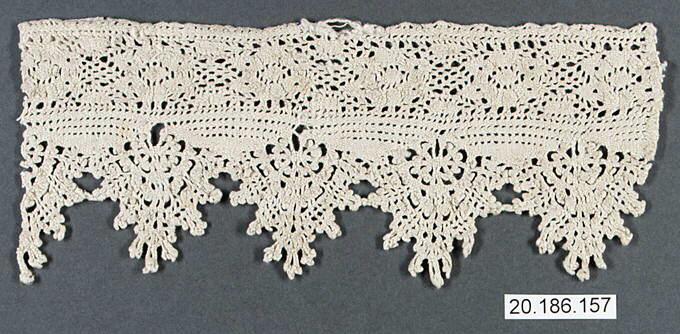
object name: edging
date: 1601-1700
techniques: lace